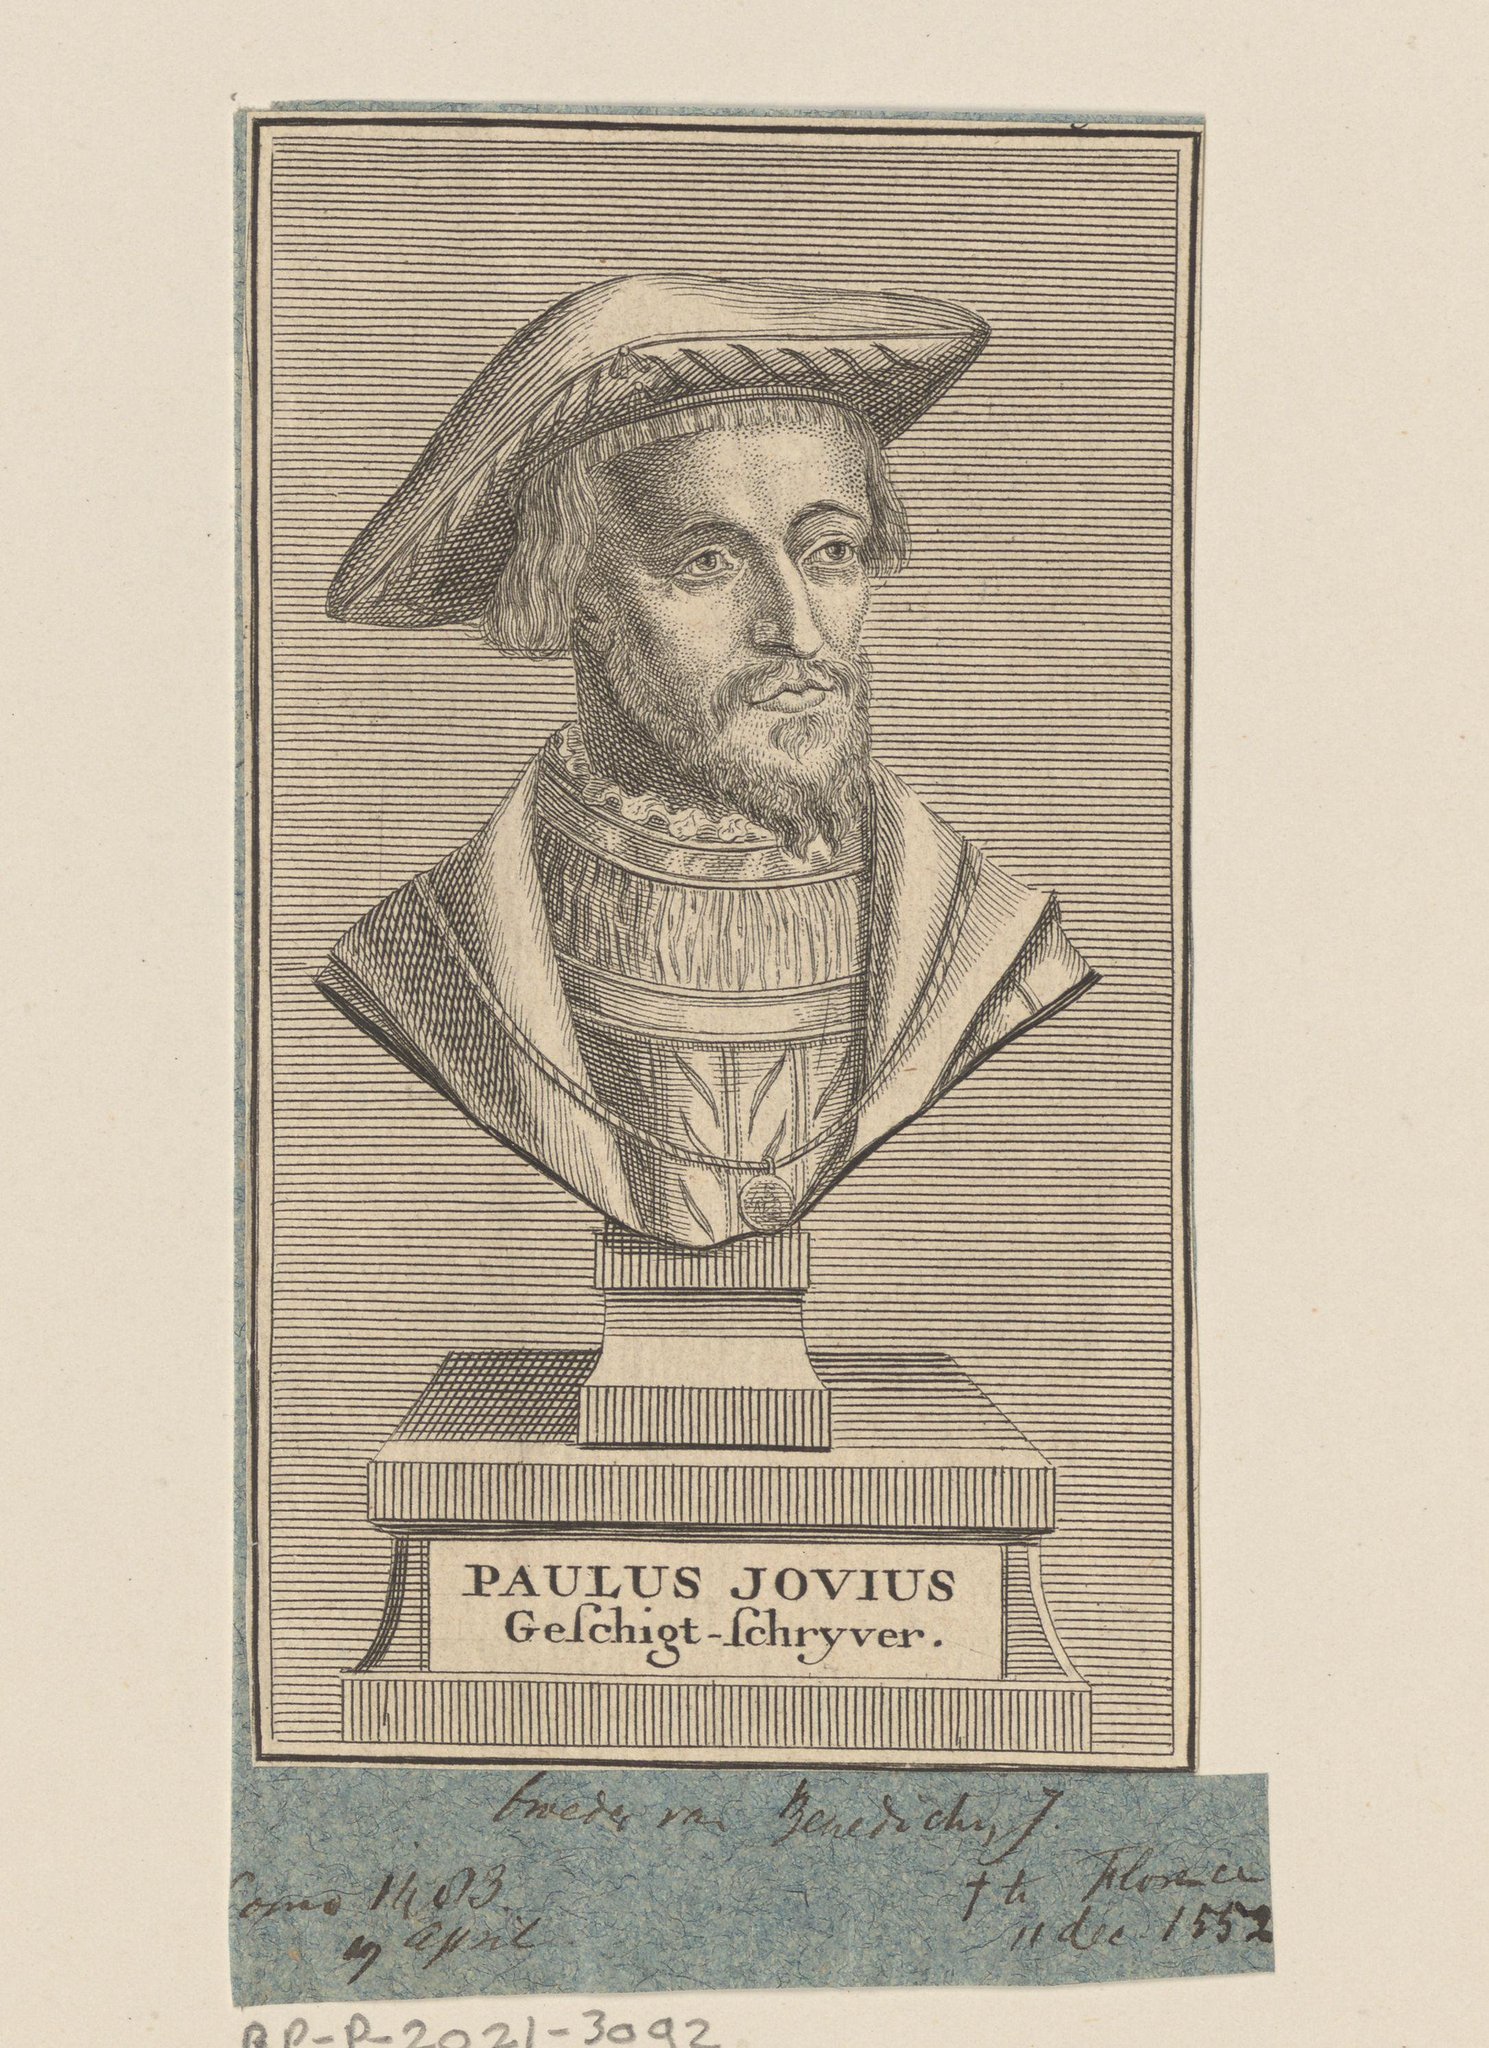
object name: print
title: Portret van Paolo Giovio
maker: Anonymous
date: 1735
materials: paper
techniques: engraving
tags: historical persons, portrait of a writer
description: Prent waarschijnlijk uit: Leti, Gregorio. Het leven van keizer Karel, den Vyfden. Leiden: Jan en Hendrik van der Deyster, Amsterdam: Johannes en Geertrui de Ruiter, 1735, dl. 4, p. 682.